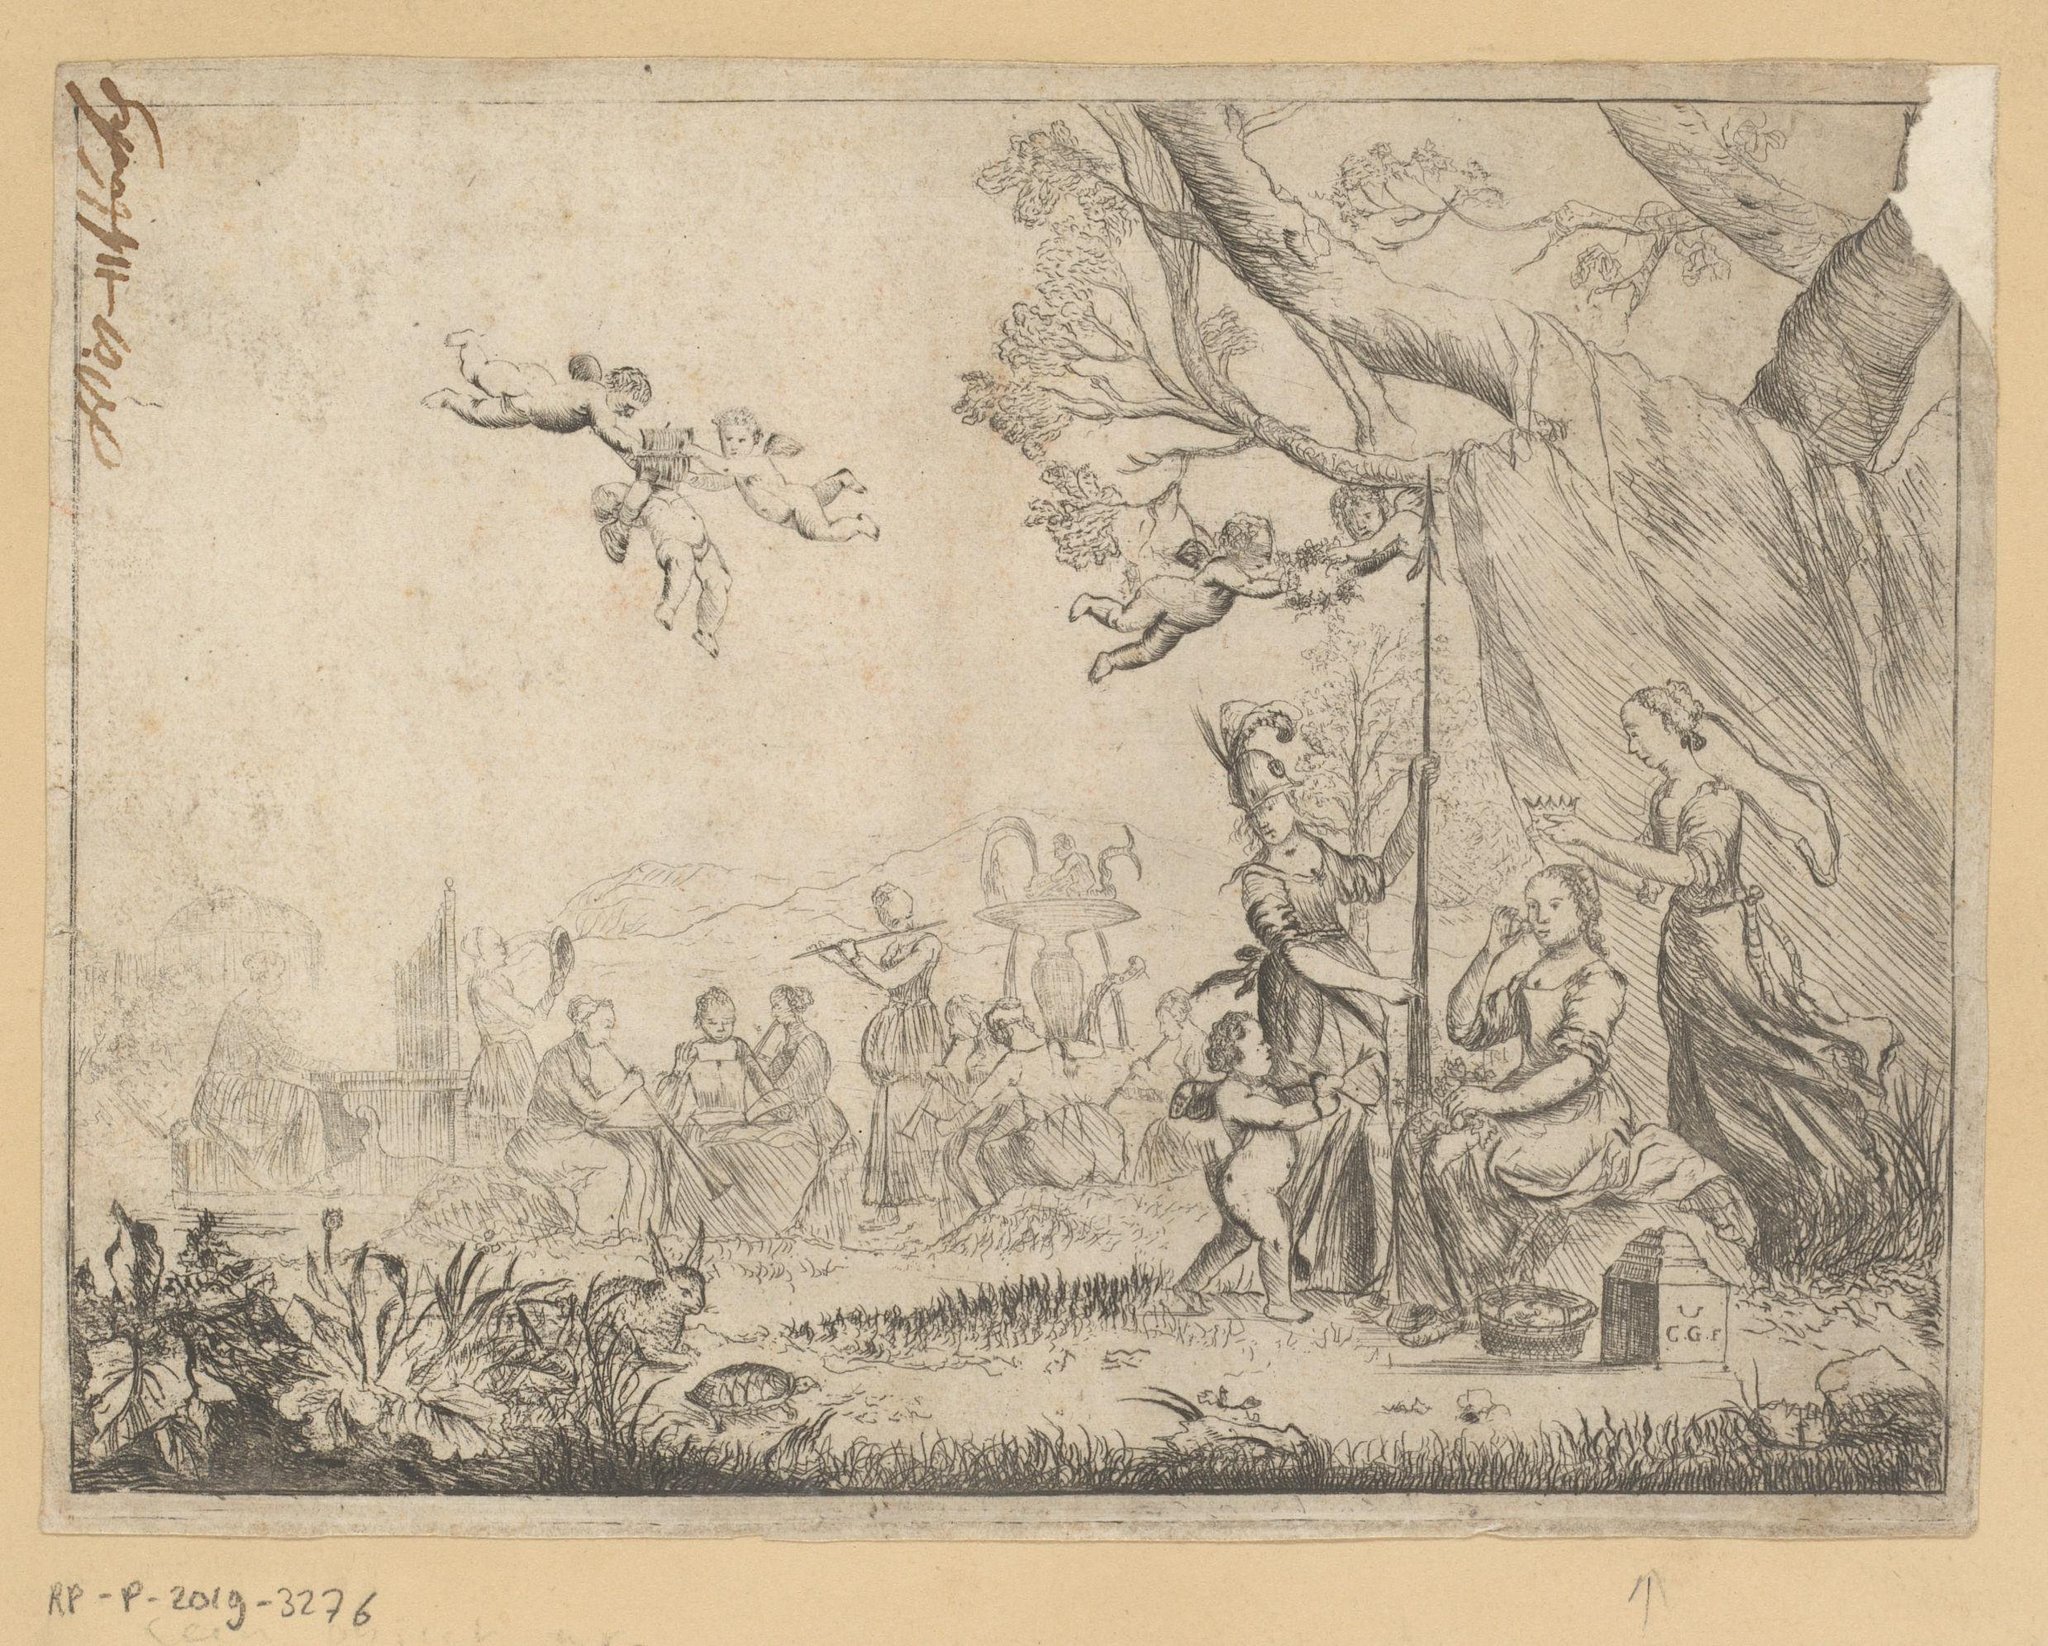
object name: print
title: Kroning van een jonge vrouw door Minerva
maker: monogrammist c.g.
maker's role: print maker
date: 1600-1699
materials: paper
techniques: etching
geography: netherlands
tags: crown (symbol of sovereignty), (story of) minerva (pallas, athena), more than one musician with instrument - cc - 'concert champêtre'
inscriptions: inscription: ‘[...] f11-10.0s (?)’